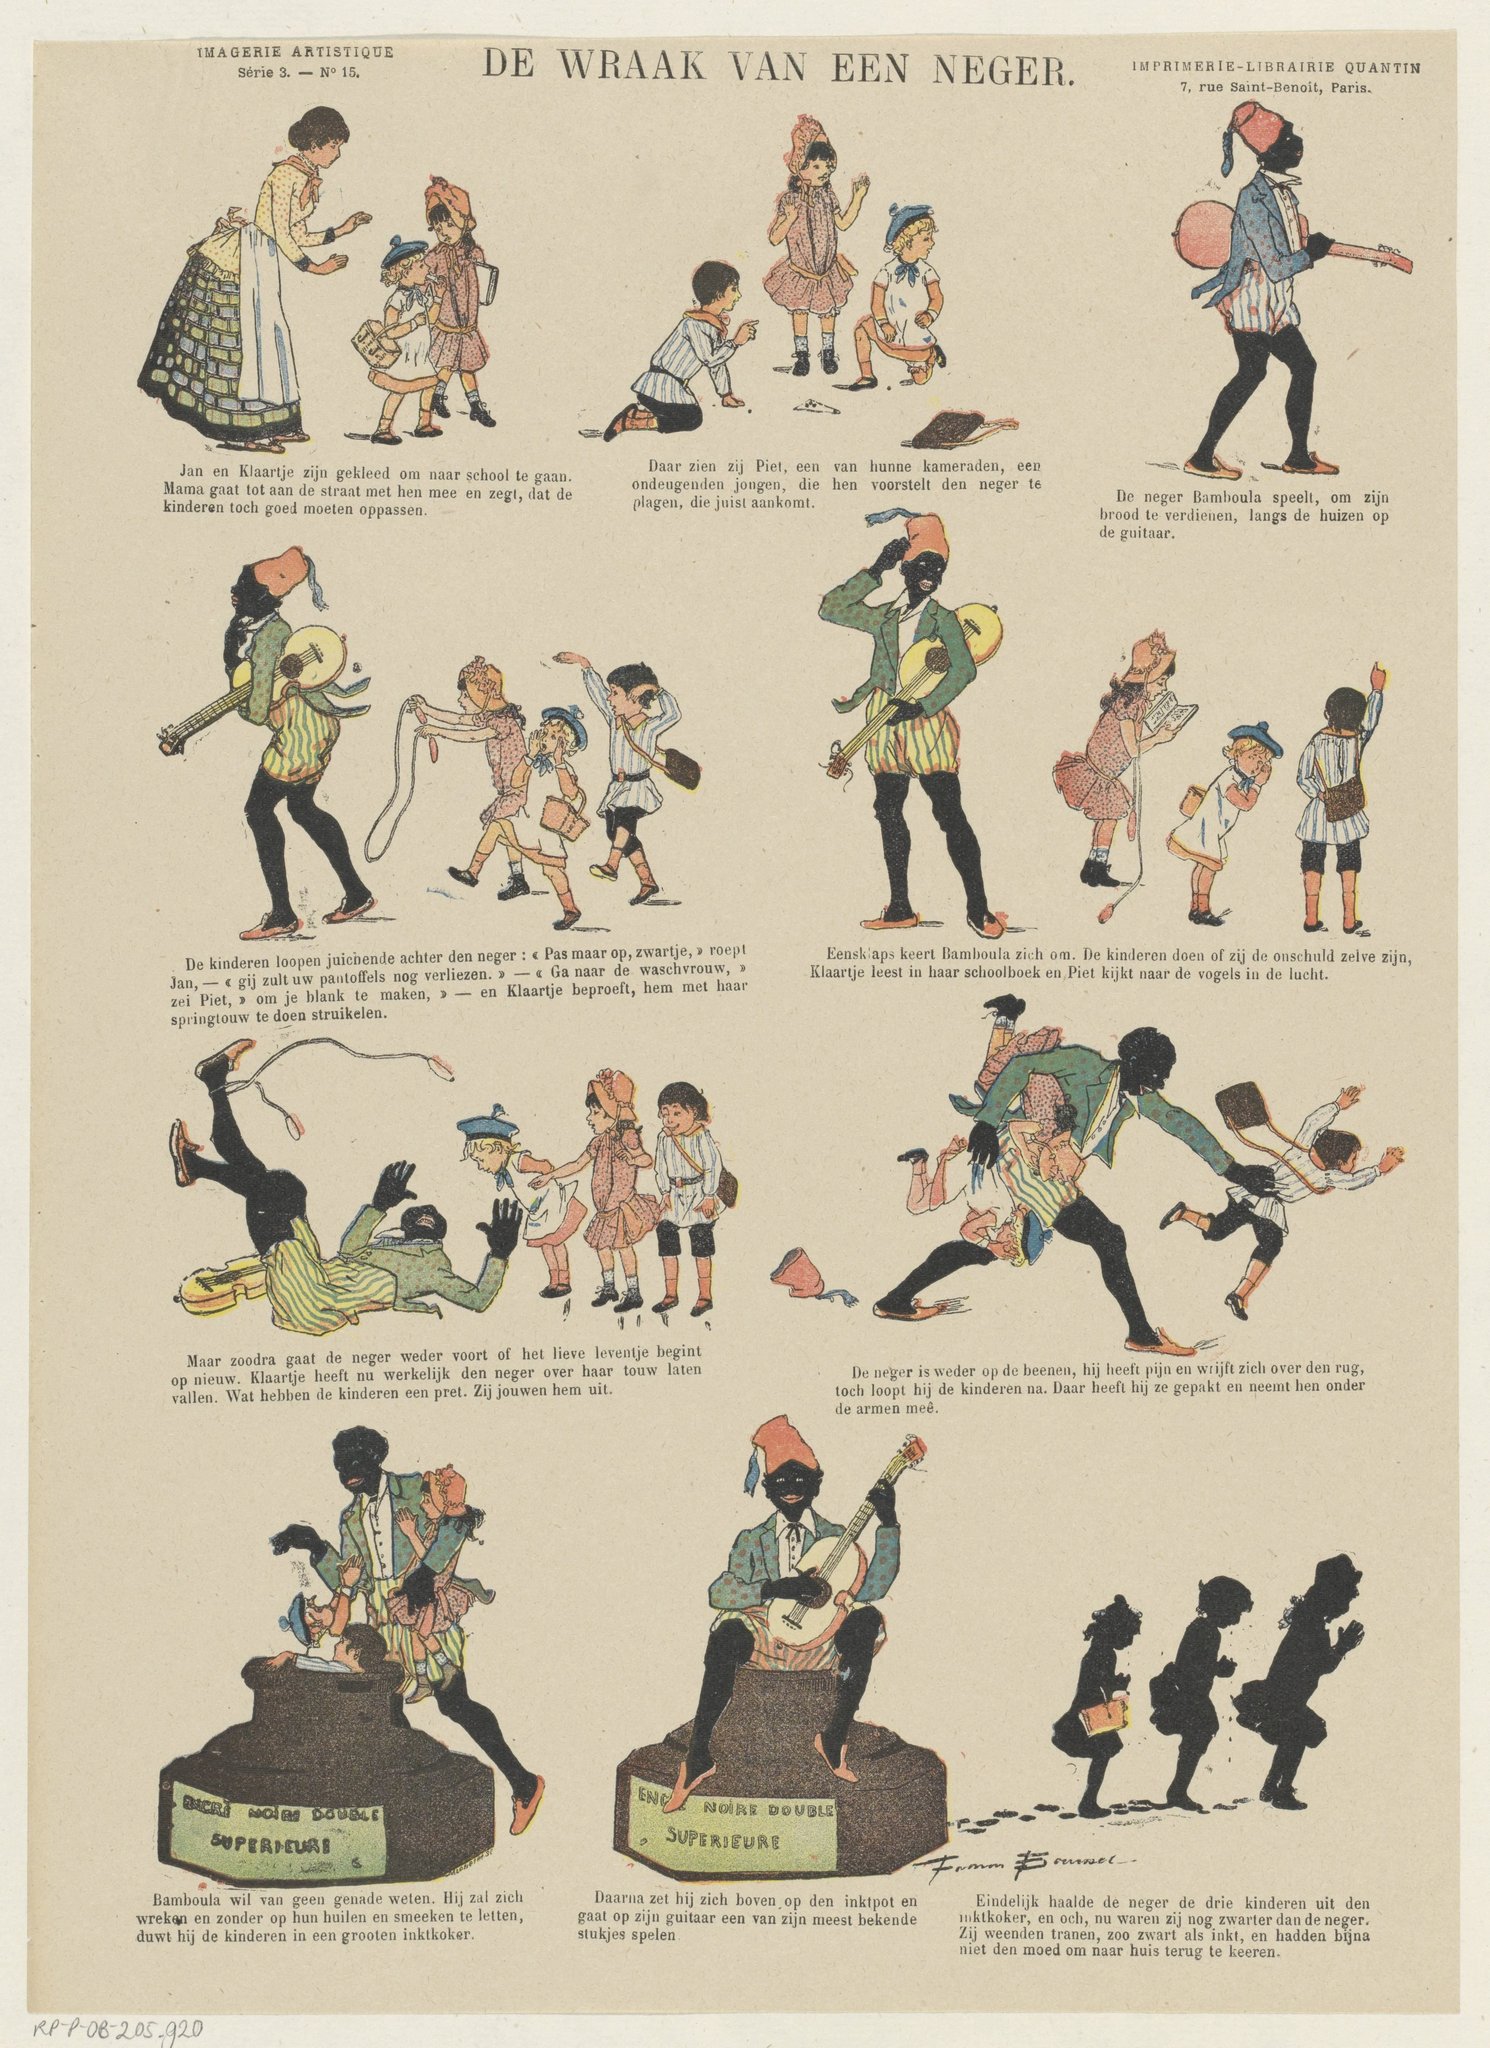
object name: popular print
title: Imagerie Artistique / Série 3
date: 1876-1890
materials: paper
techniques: lithograph, letterpress printing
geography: paris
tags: correction of naughty children, mocking, insulting; teasing, tales and fairy tales, teasing (children's games and plays)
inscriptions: collector's mark: Lugt 2760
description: Blad met 10 voorstellingen over de wraak van een zwarte man. Onder elke voorstelling een onderschrift. Genummerd linksboven: Série 3. - No. 15.